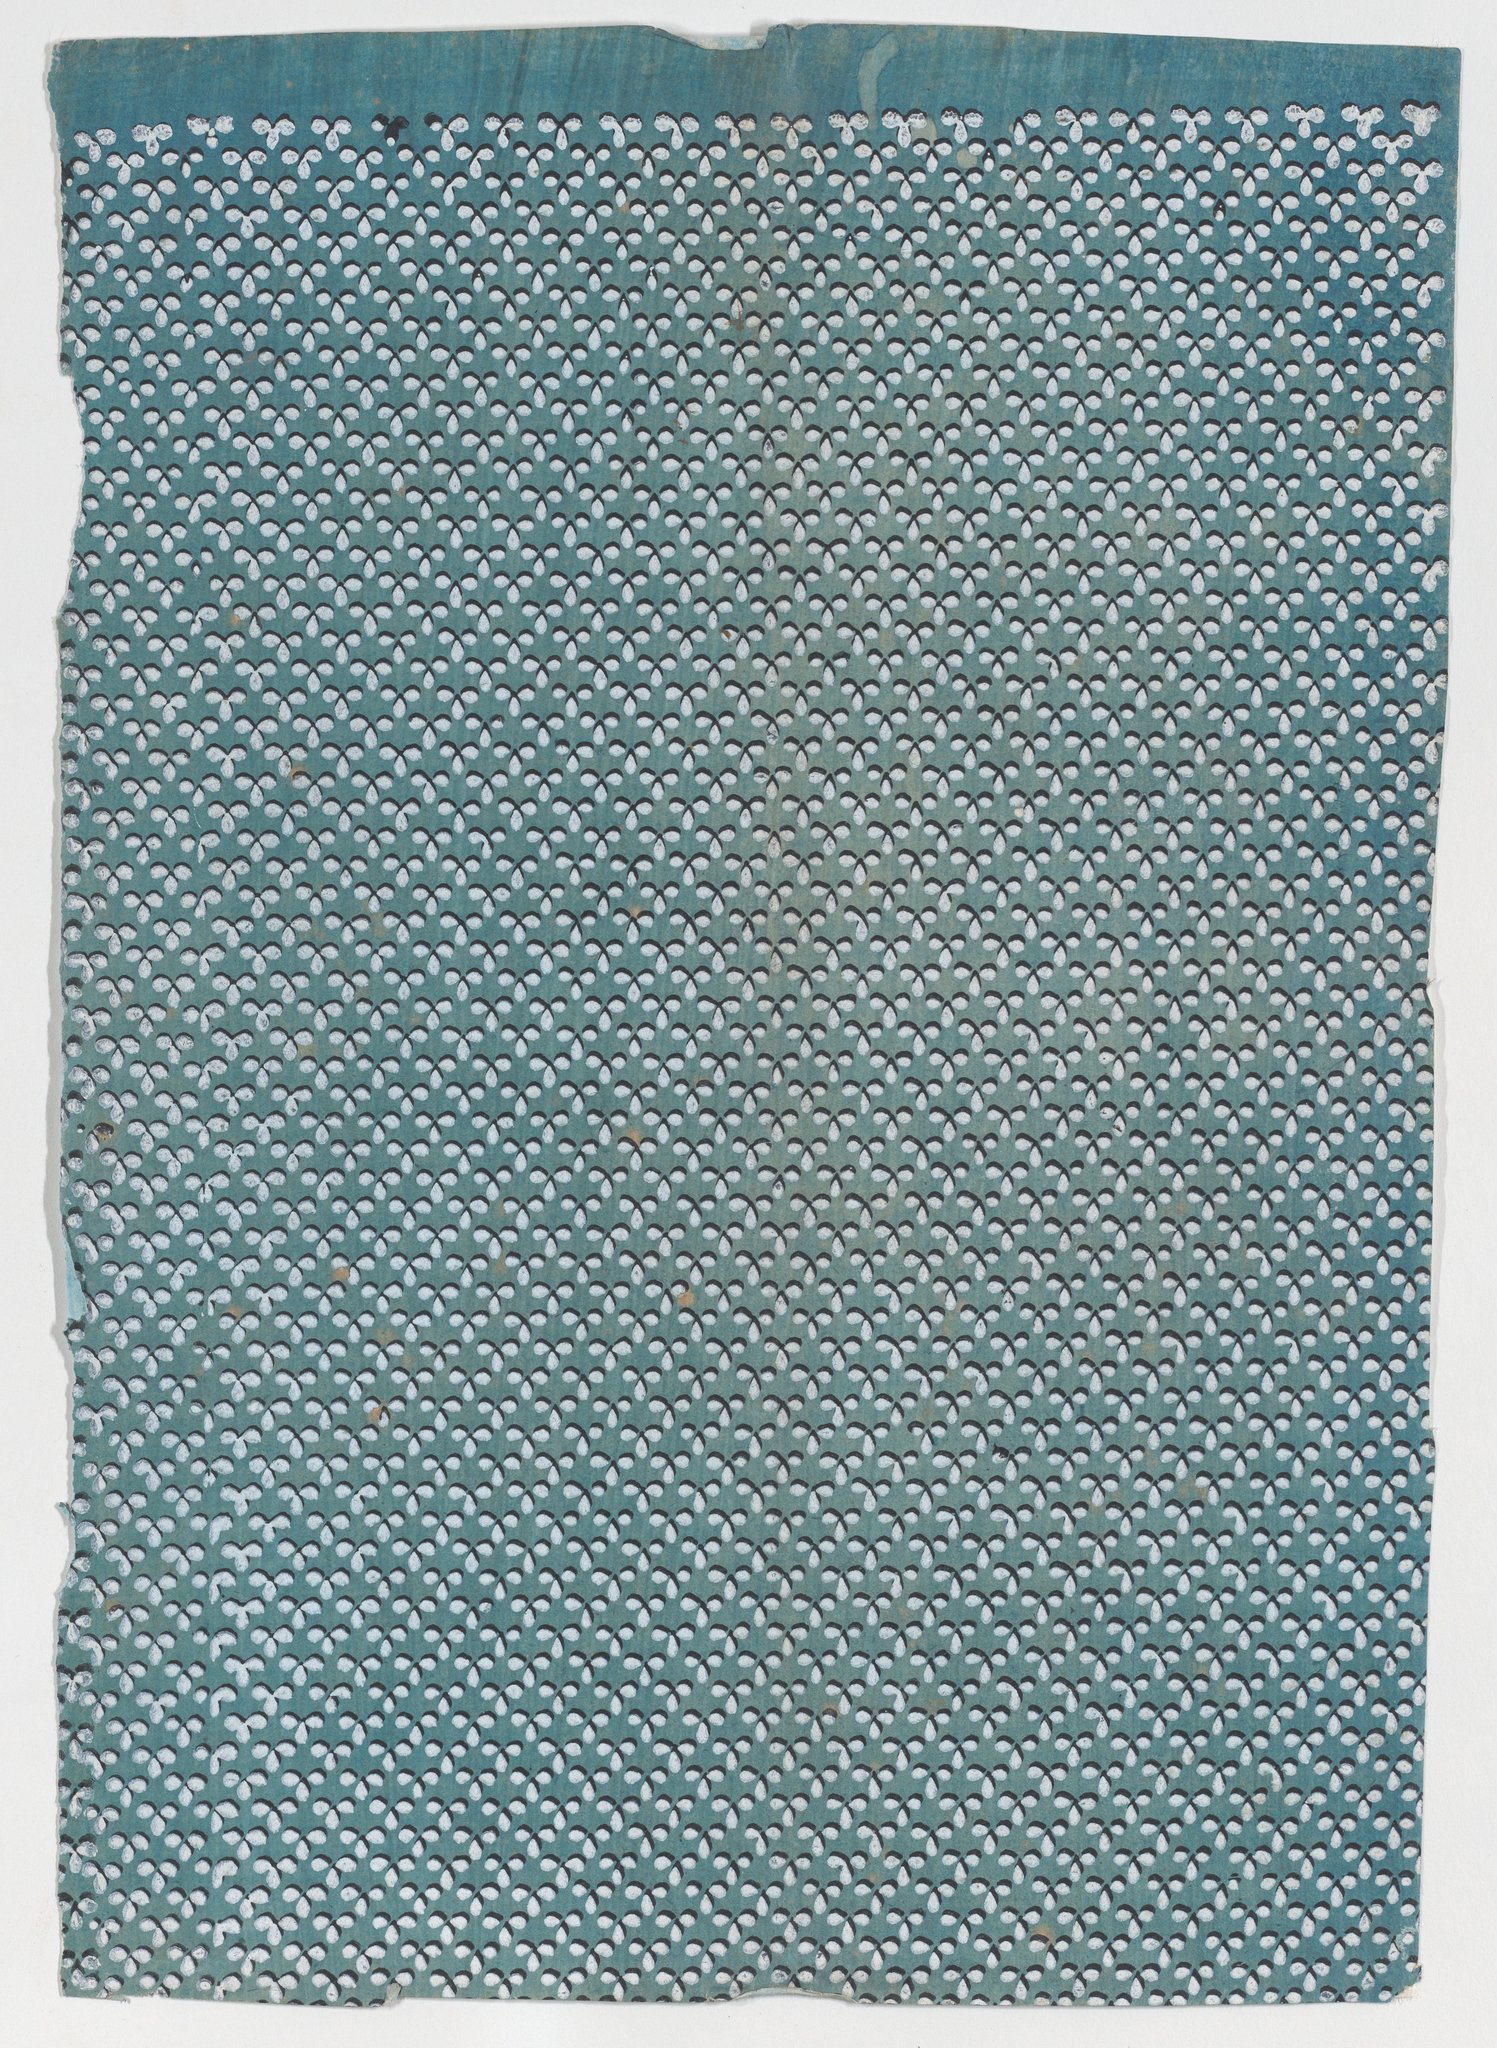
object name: print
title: Sheet with overall pattern of dots in triangular shapes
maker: Anonymous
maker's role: artist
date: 1801-1900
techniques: relief print